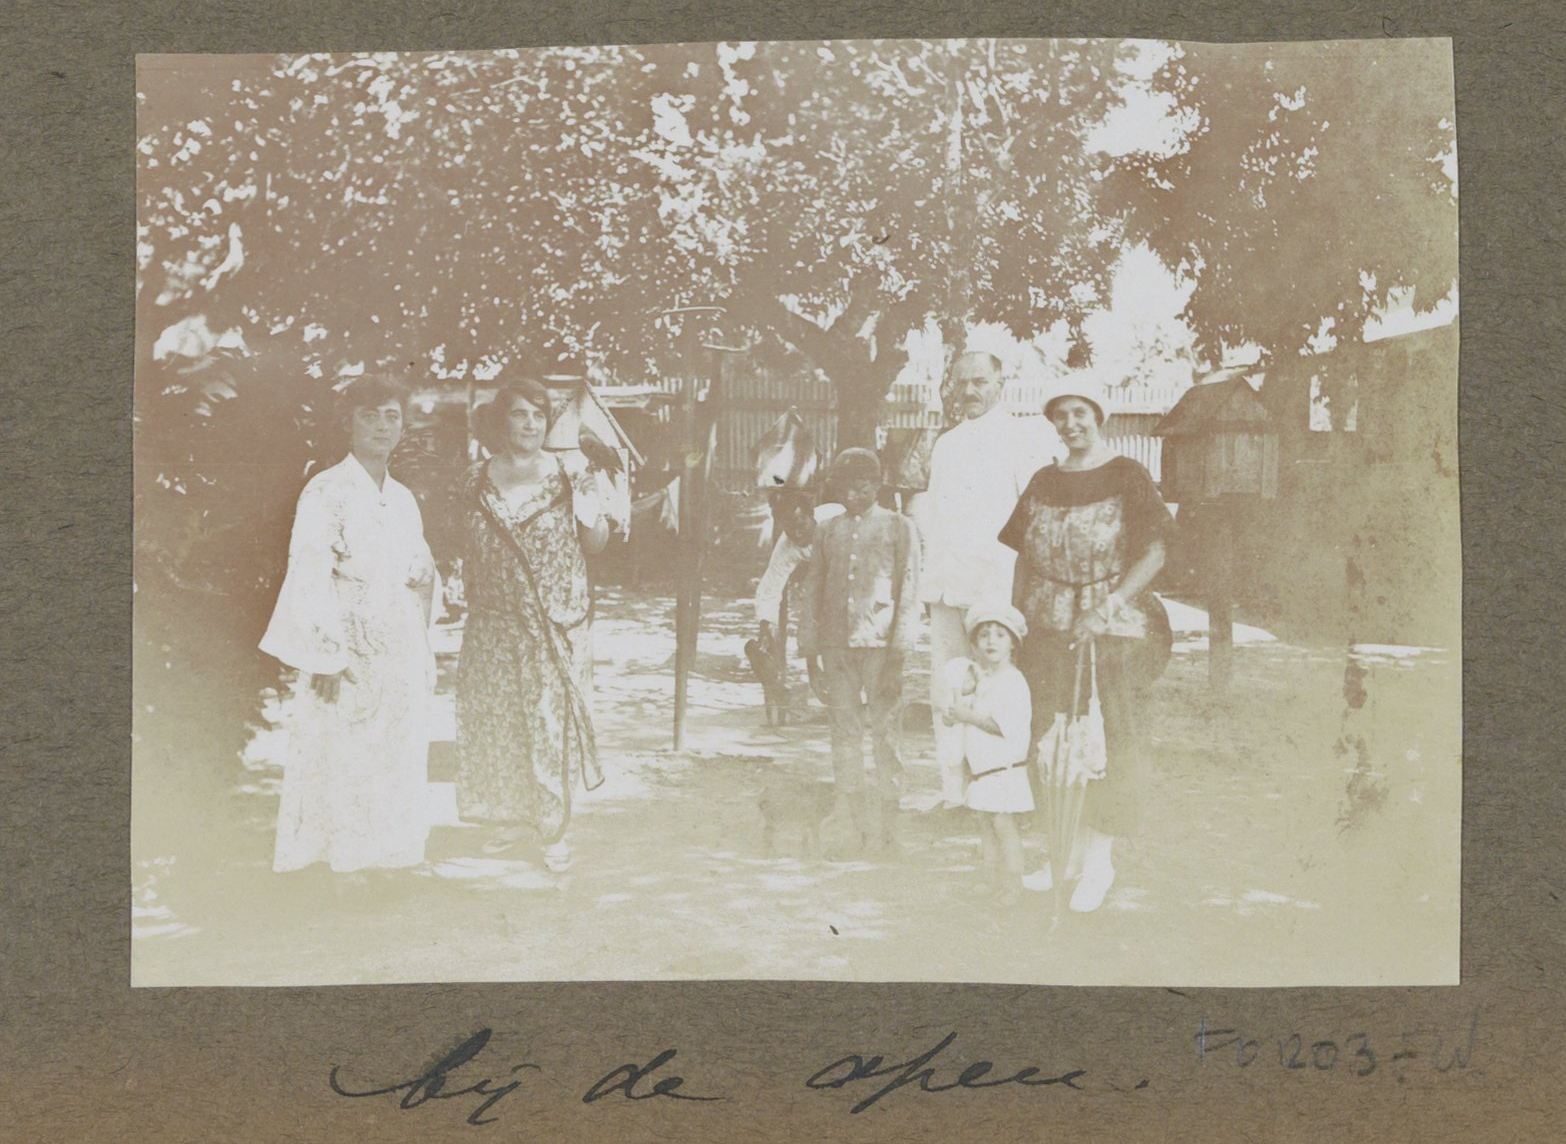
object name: photograph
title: Gezelschap staand bij apen in Suriname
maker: Anonymous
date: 1920-1930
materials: photographic support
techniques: daylight paper print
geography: suriname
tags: adult woman, adult man, suriname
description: Onderdeel van fotoalbum van een onbekende Nederlandse familie met opnames van Suriname, Europa en Nederlands-Indië.